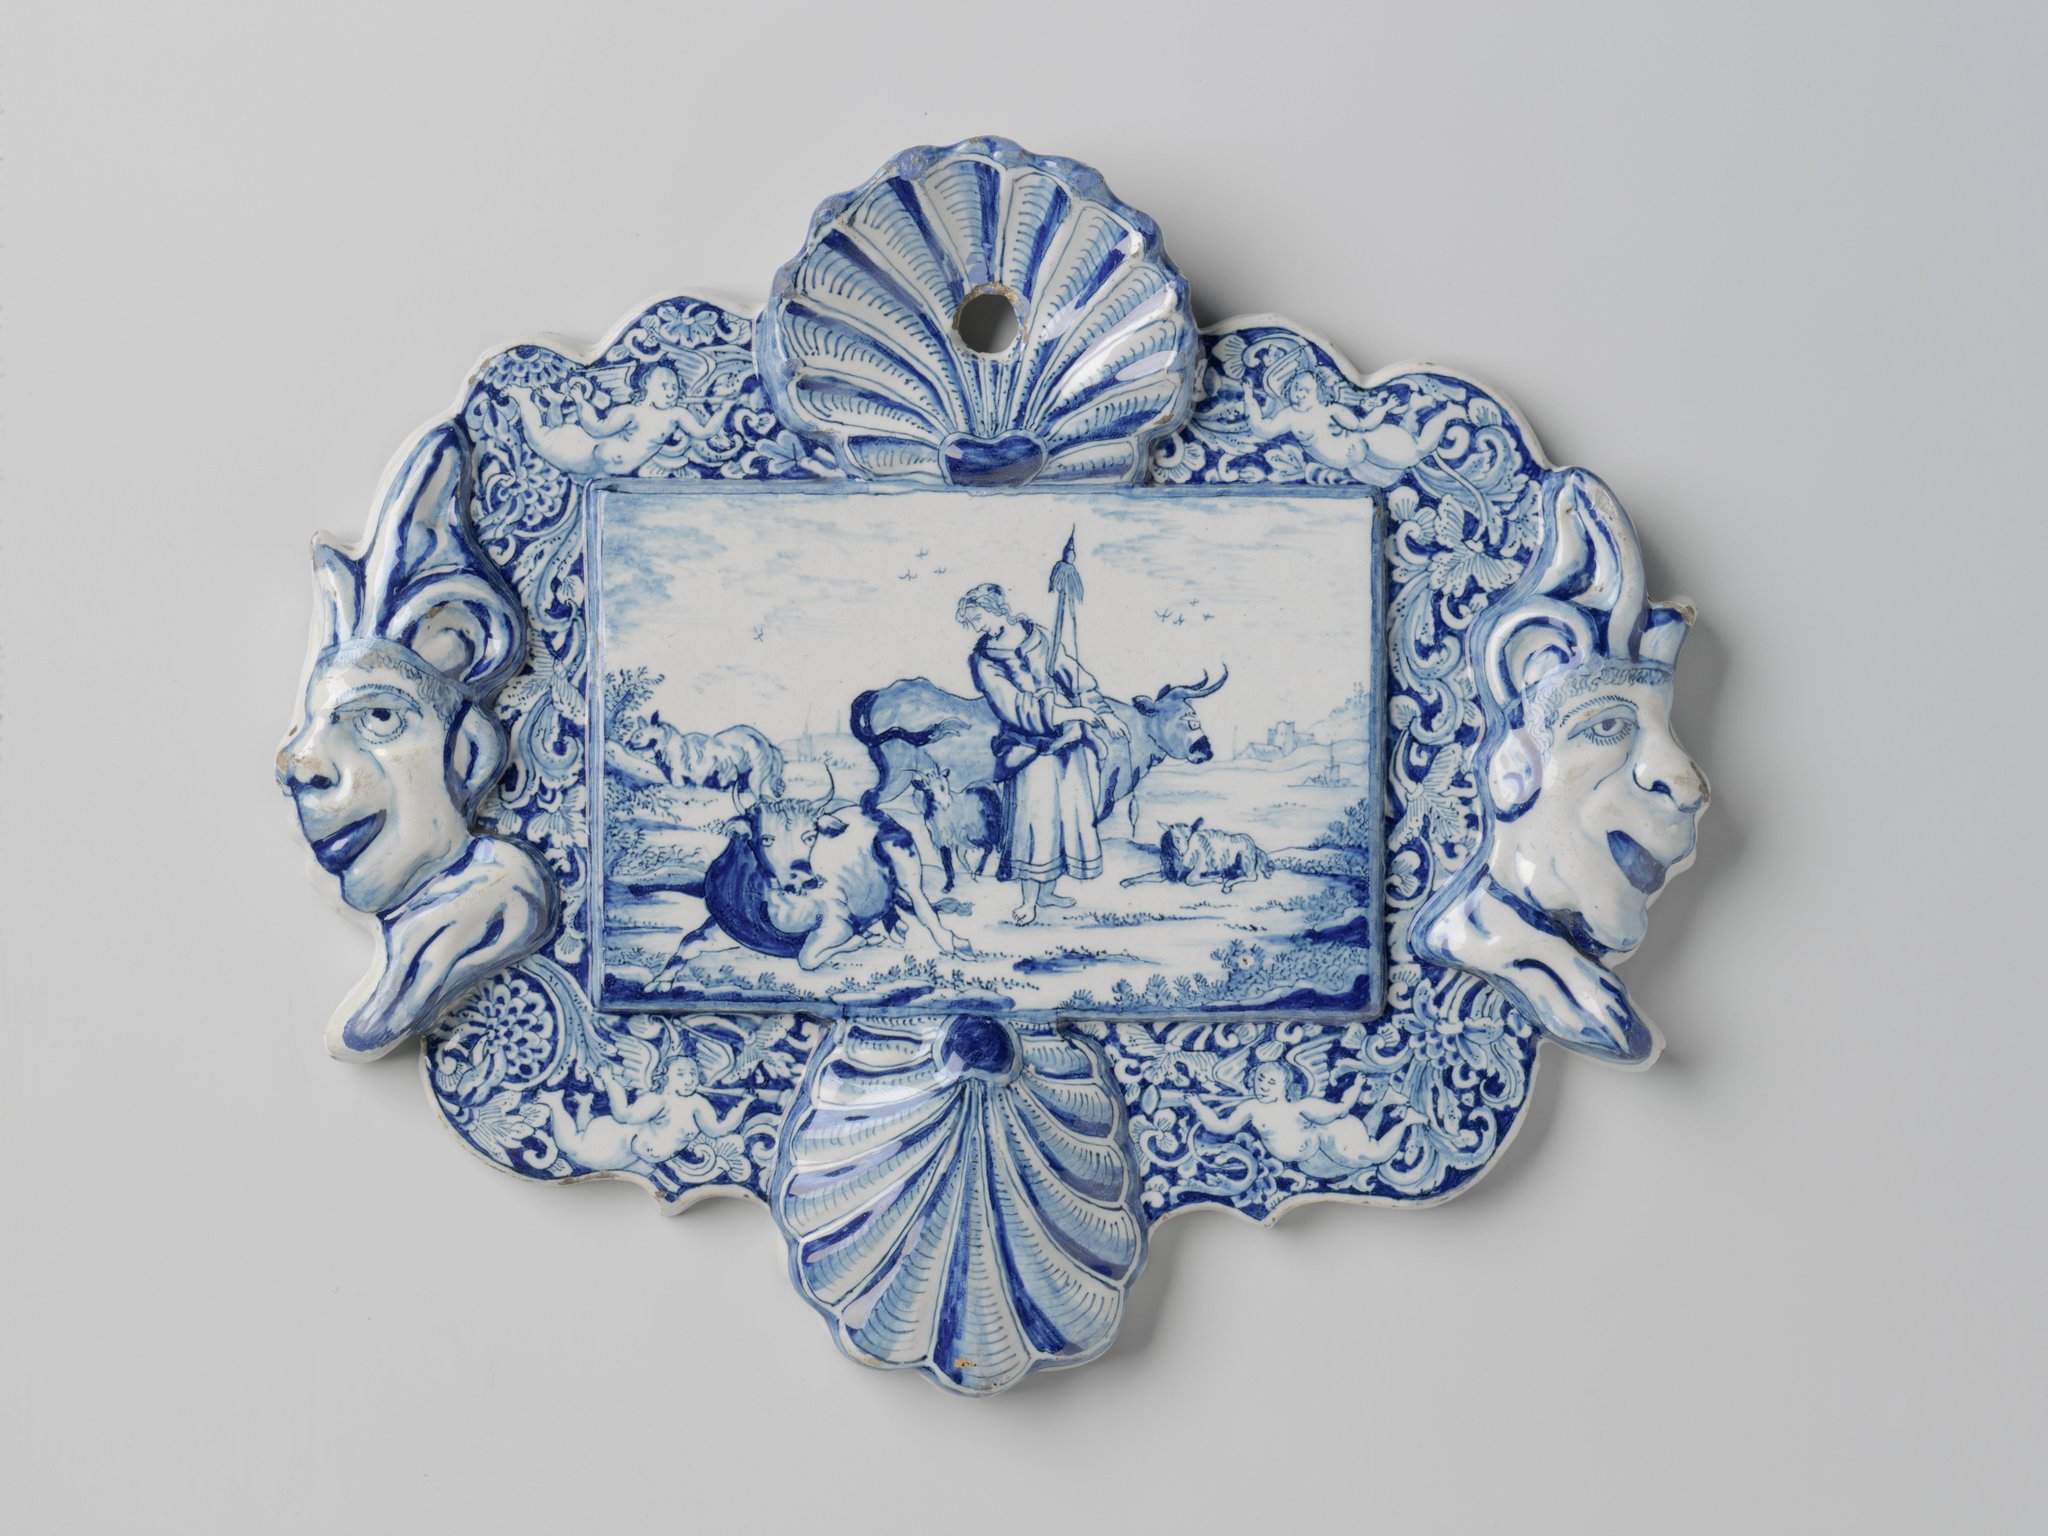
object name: plate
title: Plaat, rechthoekig, met in reliëf twee schelpen en twee narrenkoppen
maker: johannes aelmis (i)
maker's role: tegelschilder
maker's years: 1674-1755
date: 1725-1750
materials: faience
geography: rotterdam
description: Plaat van faïence, rechthoekig, met in reliëf twee schelpen en twee narrenkoppen. In het midden in blauw een koeienhoedster